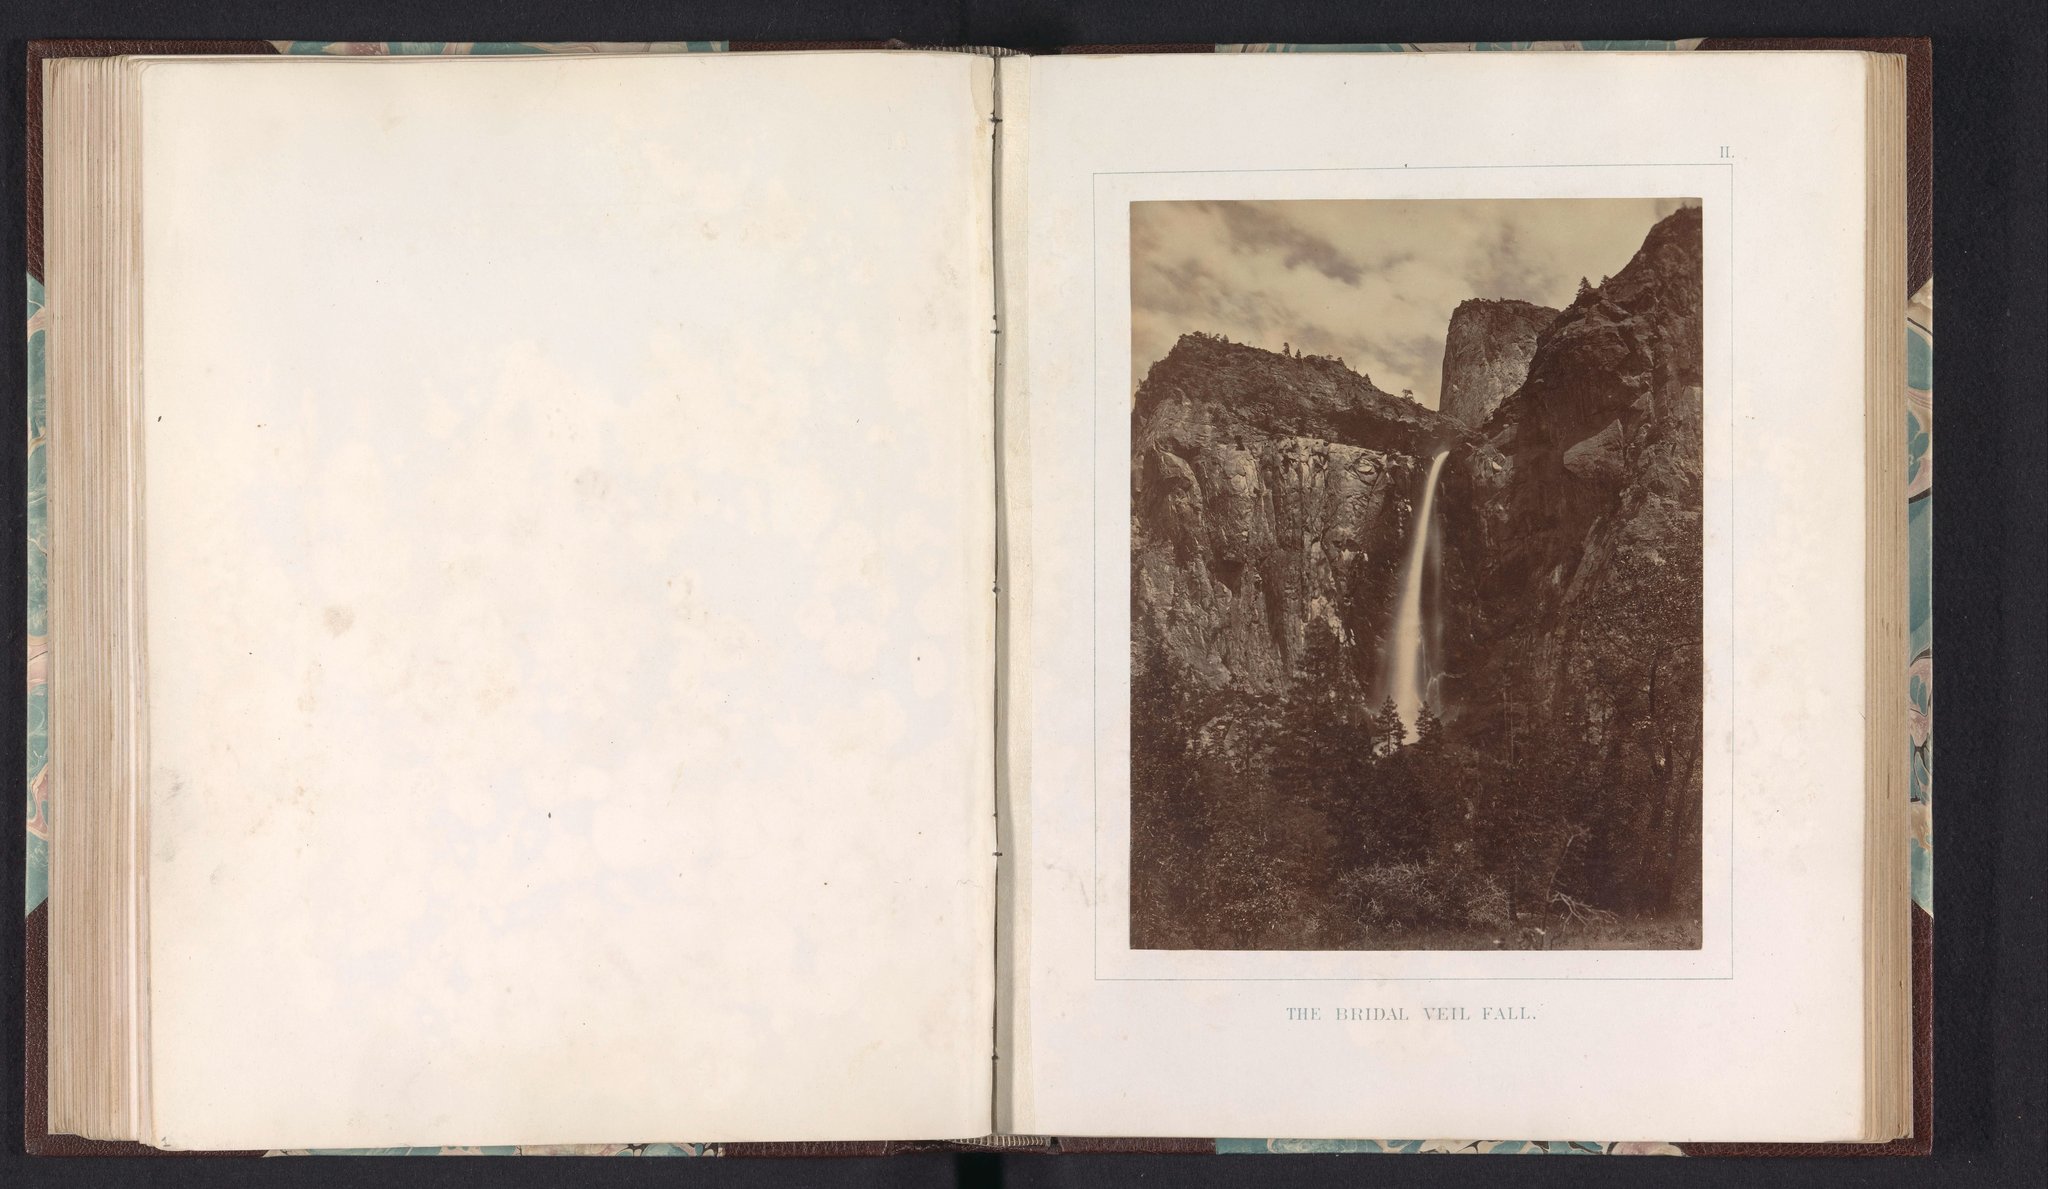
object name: page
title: Gezicht op de Bridalveilwaterval in de Yosemite Valley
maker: carleton e. watkins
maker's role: fotograaf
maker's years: 1829-1916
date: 1860-1868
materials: photographic support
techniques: albumen print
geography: yosemite valley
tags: dale, valley, waterfall, mountains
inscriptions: number: ‘II.’